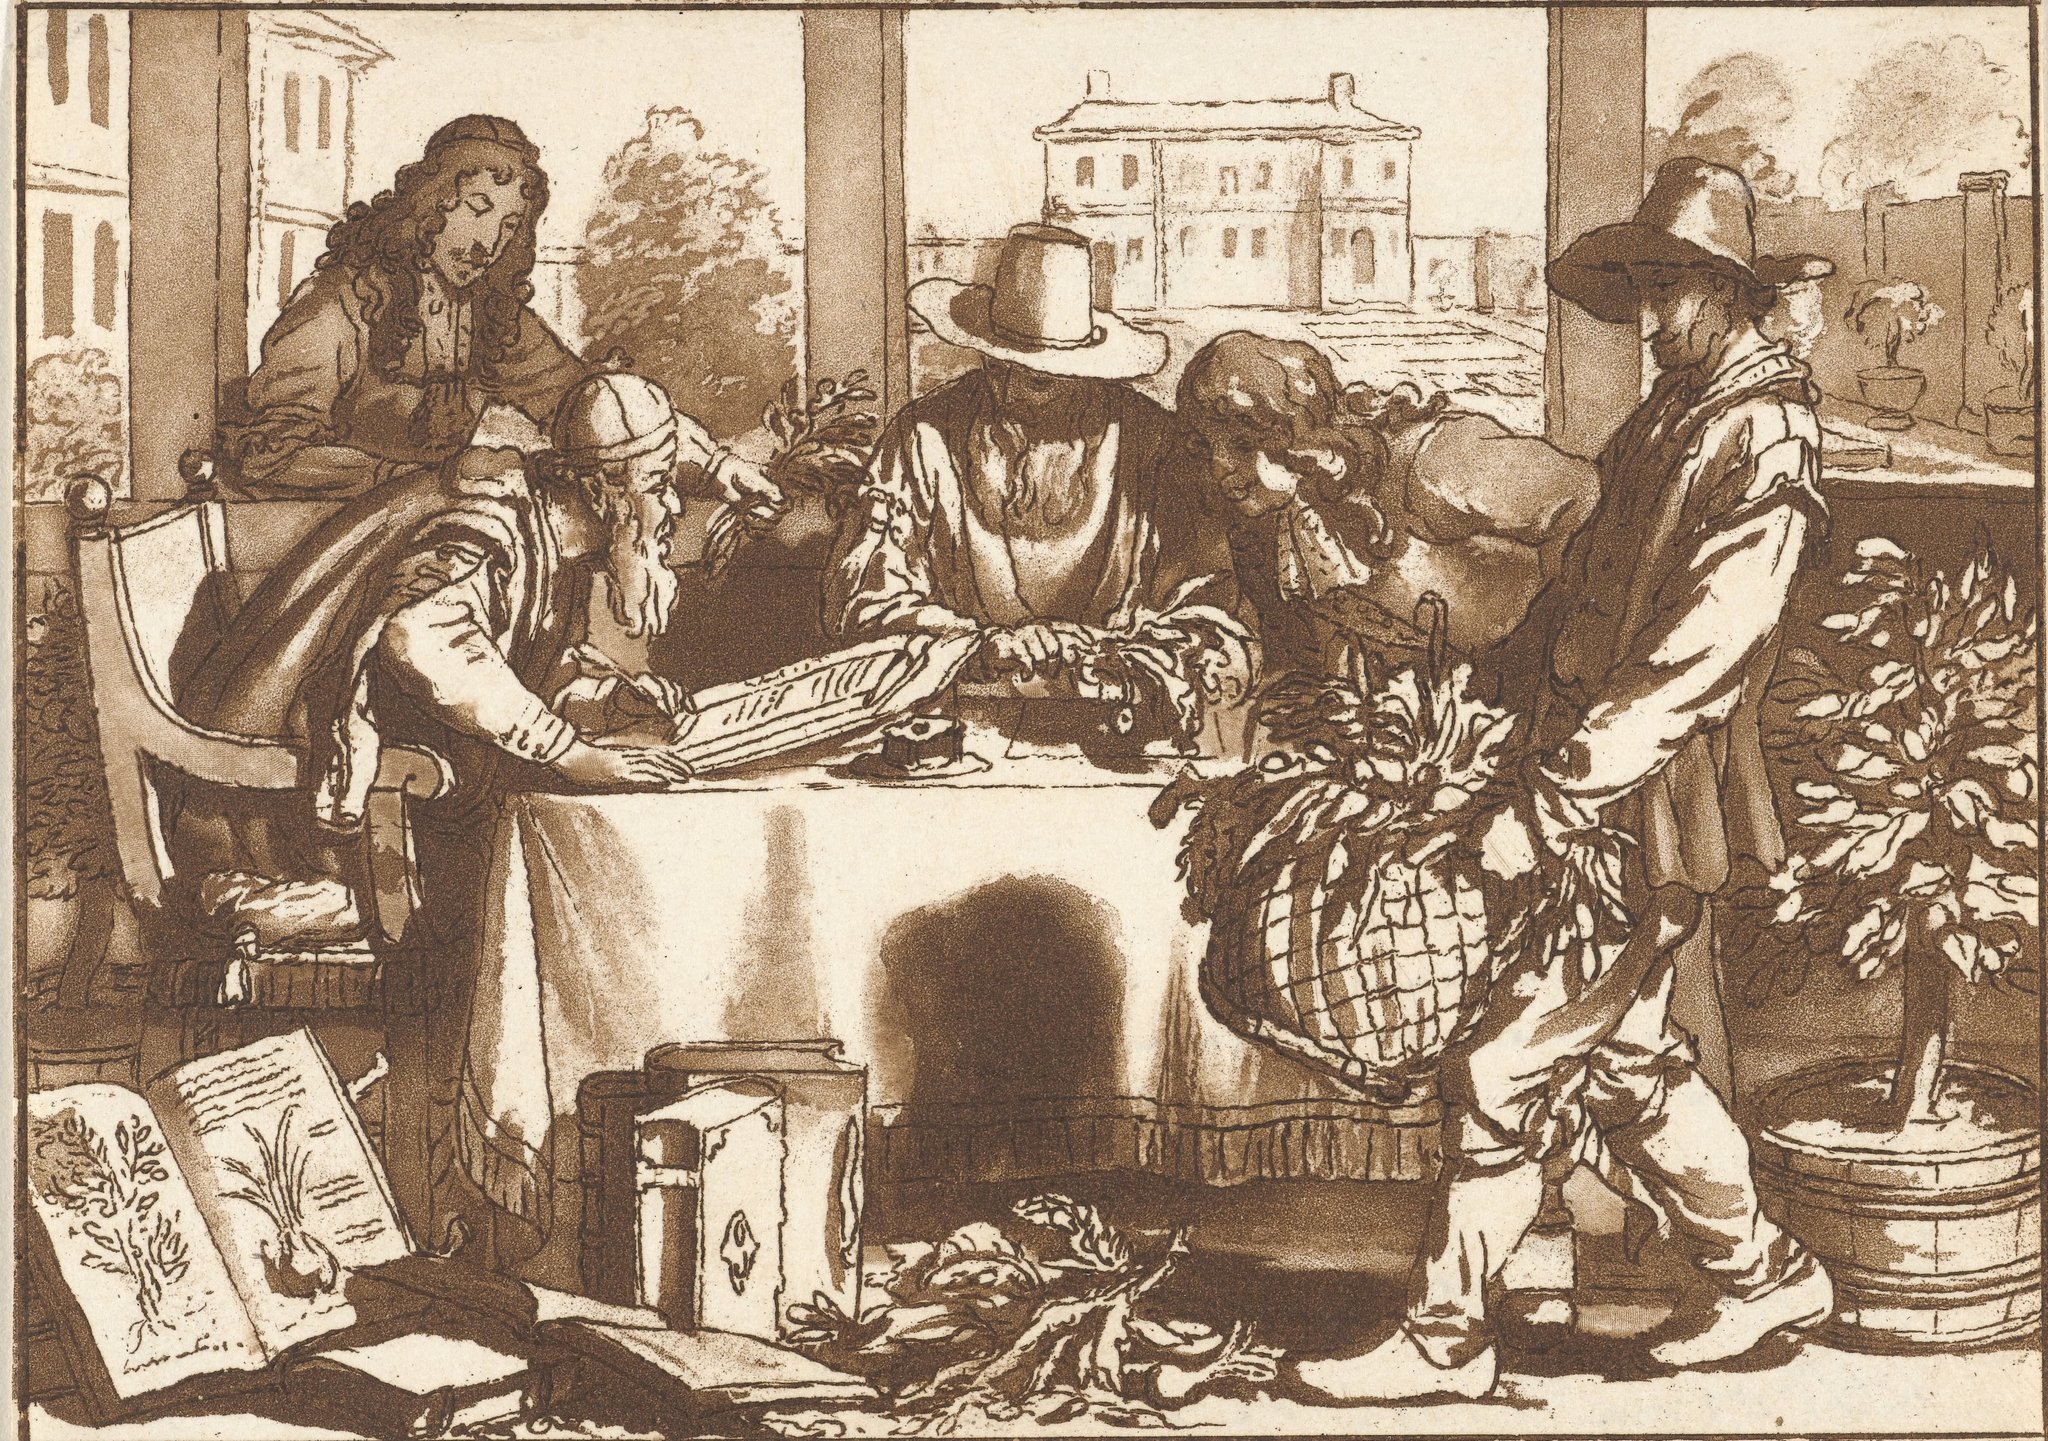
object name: print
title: Botanicus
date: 1779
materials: paper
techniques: printing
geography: amsterdam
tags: enjoying nature ~ plants, herbs and flowers, botany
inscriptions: collector's mark: Lugt 2760, collector's mark: Lugt 2228, inscription: ‘20 feb: 1779 deeze bijna voltooide Proef, vereerd aan mijn Liefste Vriend! den WEd Heer Hemsterhuis in 'S Hage / G v den Eekhout del Ploos v Amstel JC F: 1779’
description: Enkele mannen bestuderen planten aan een tafel. De oude zittende man schrijft in een boek. Rechts draagt een man een mand met planten. Door de ramen zicht op een tuin en een landhuis.